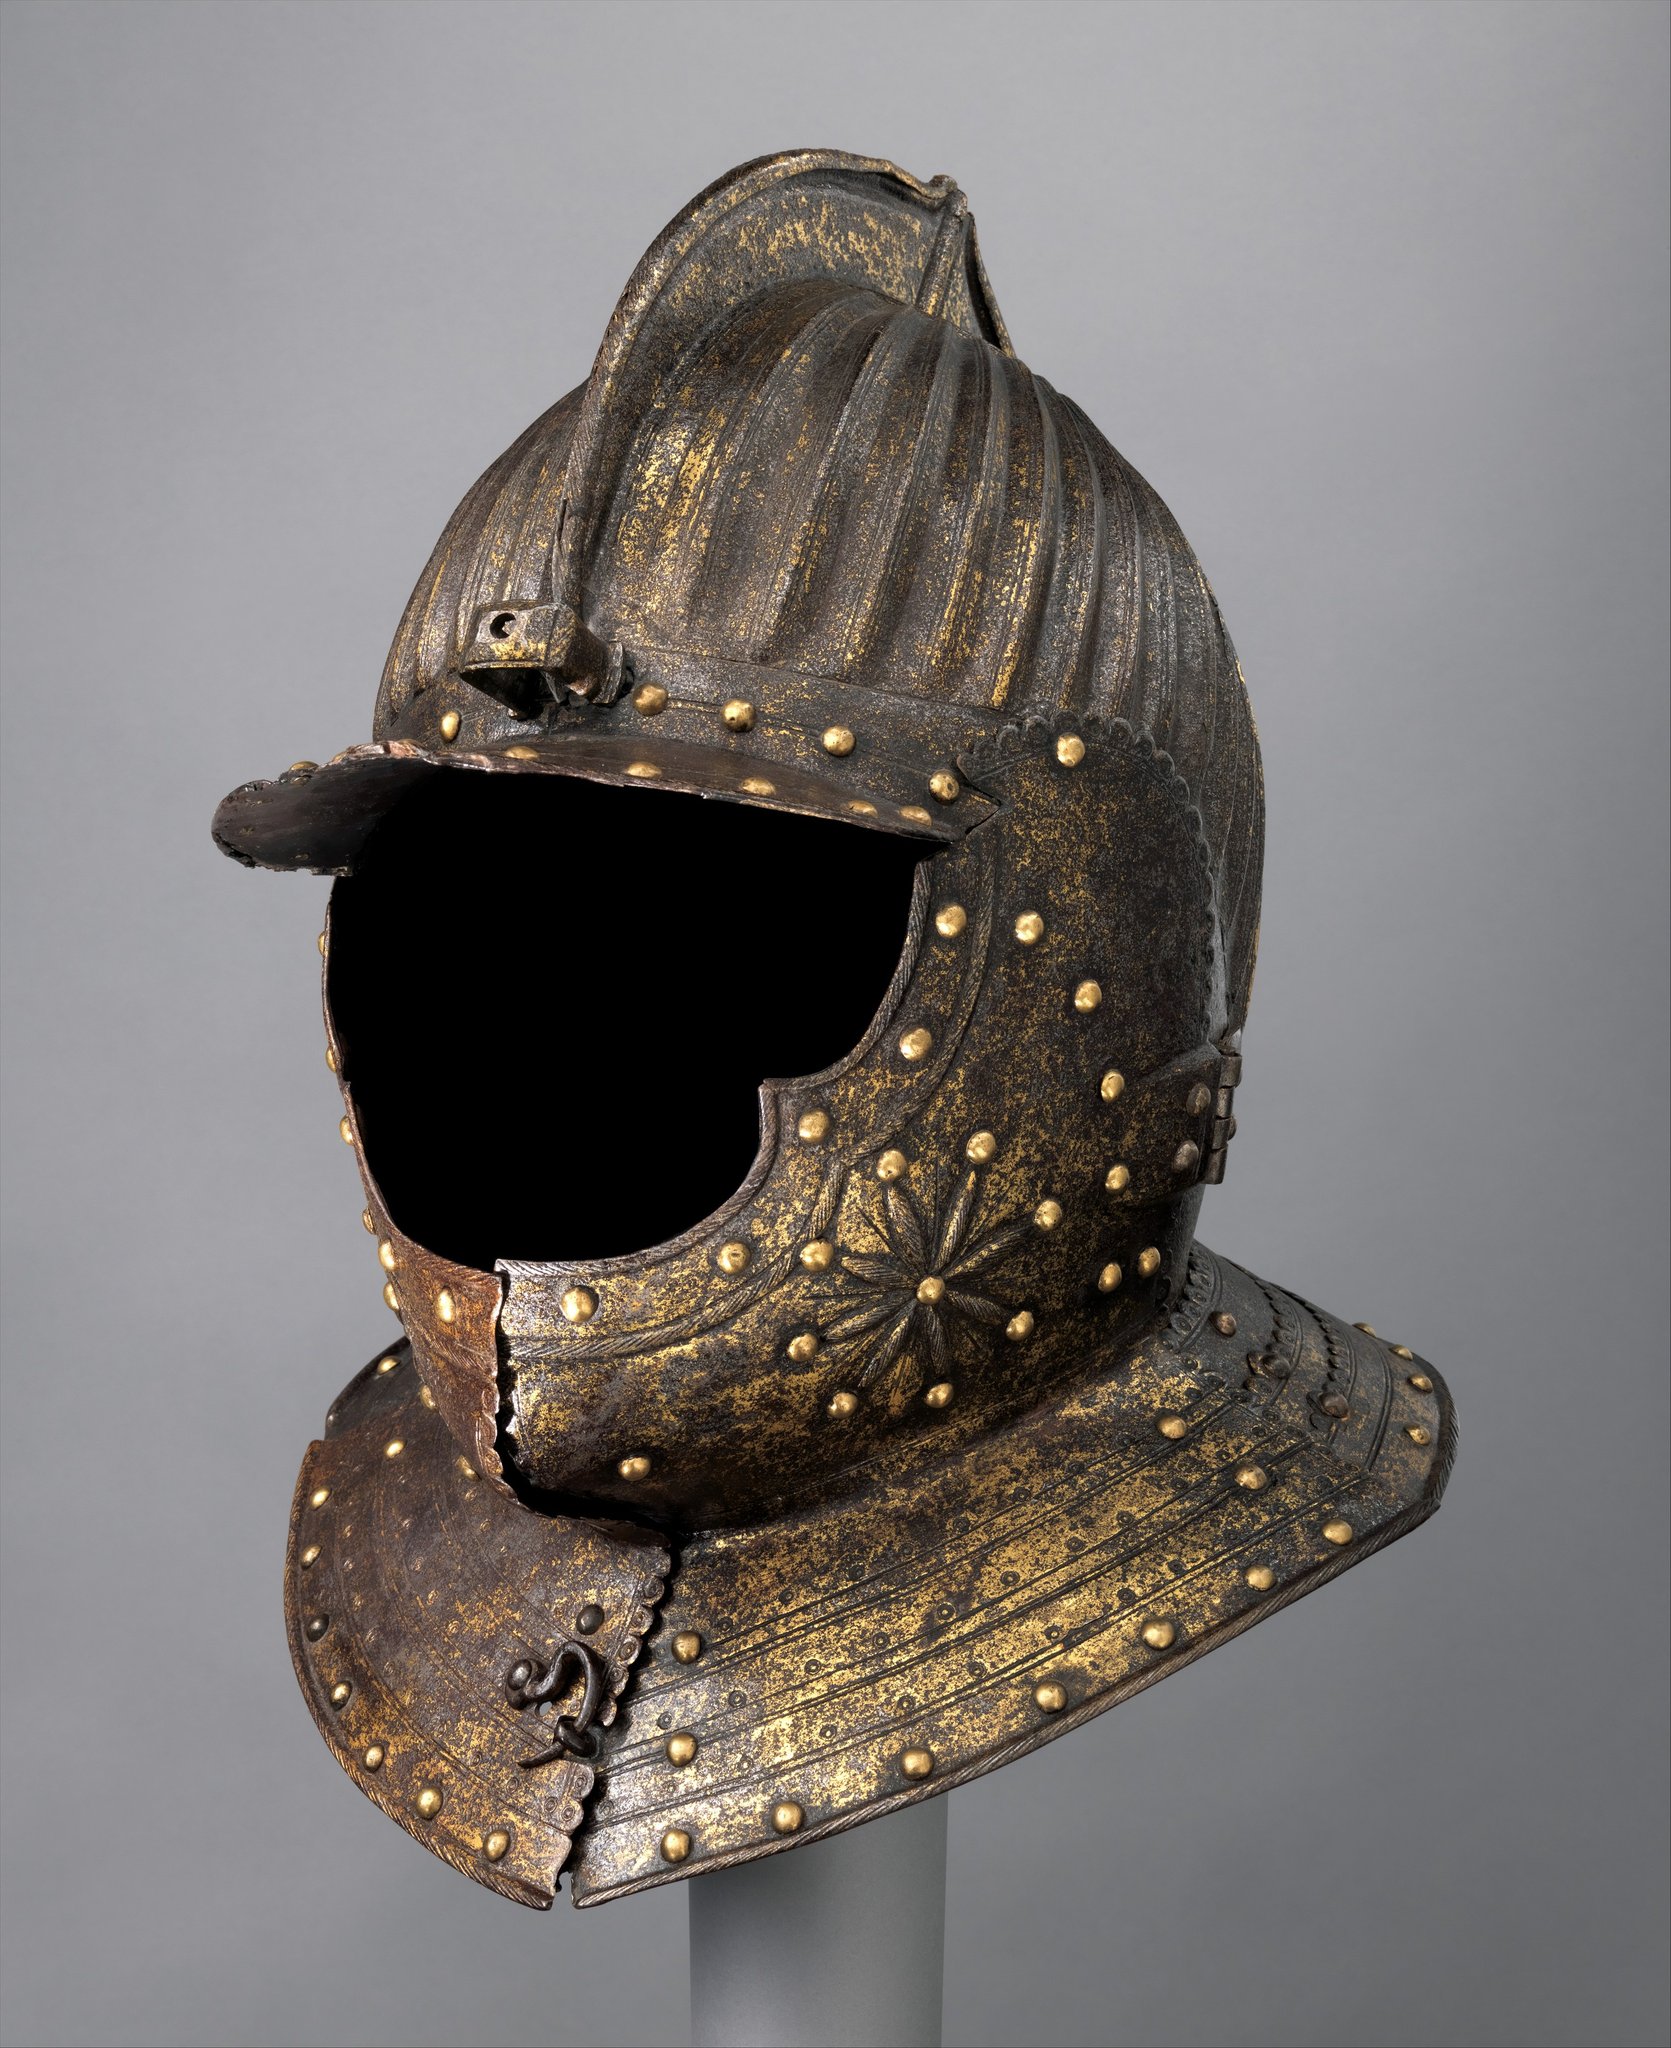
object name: burgonet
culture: french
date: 1610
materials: copper alloy, gold, steel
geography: france